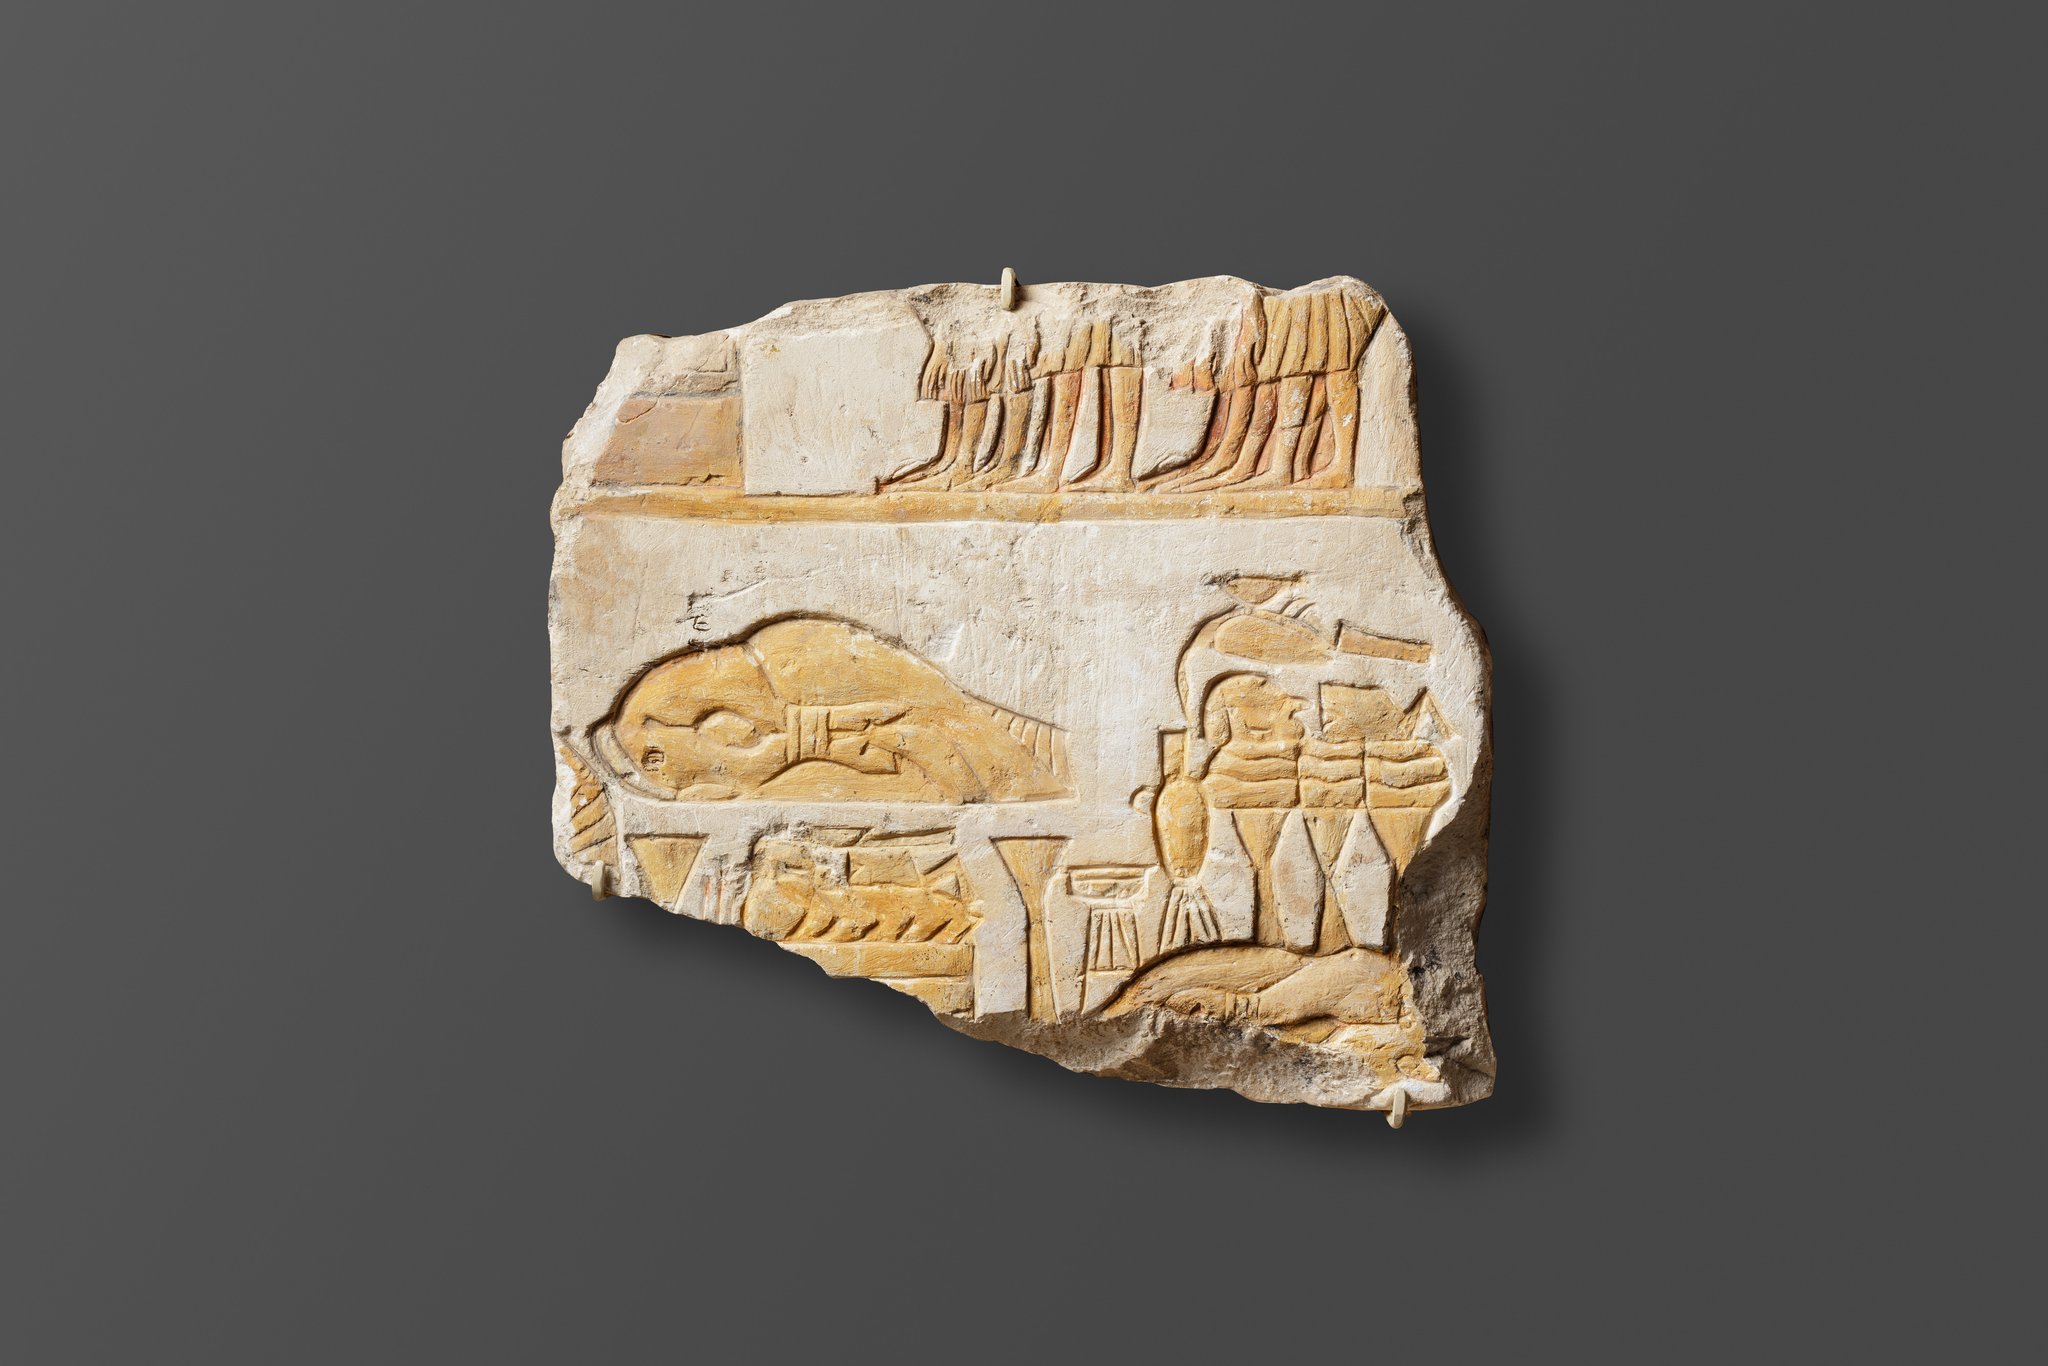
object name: talatat, offering and bowing official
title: Relief with offerings and bowing officials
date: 1353-1336 BCE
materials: limestone, paint